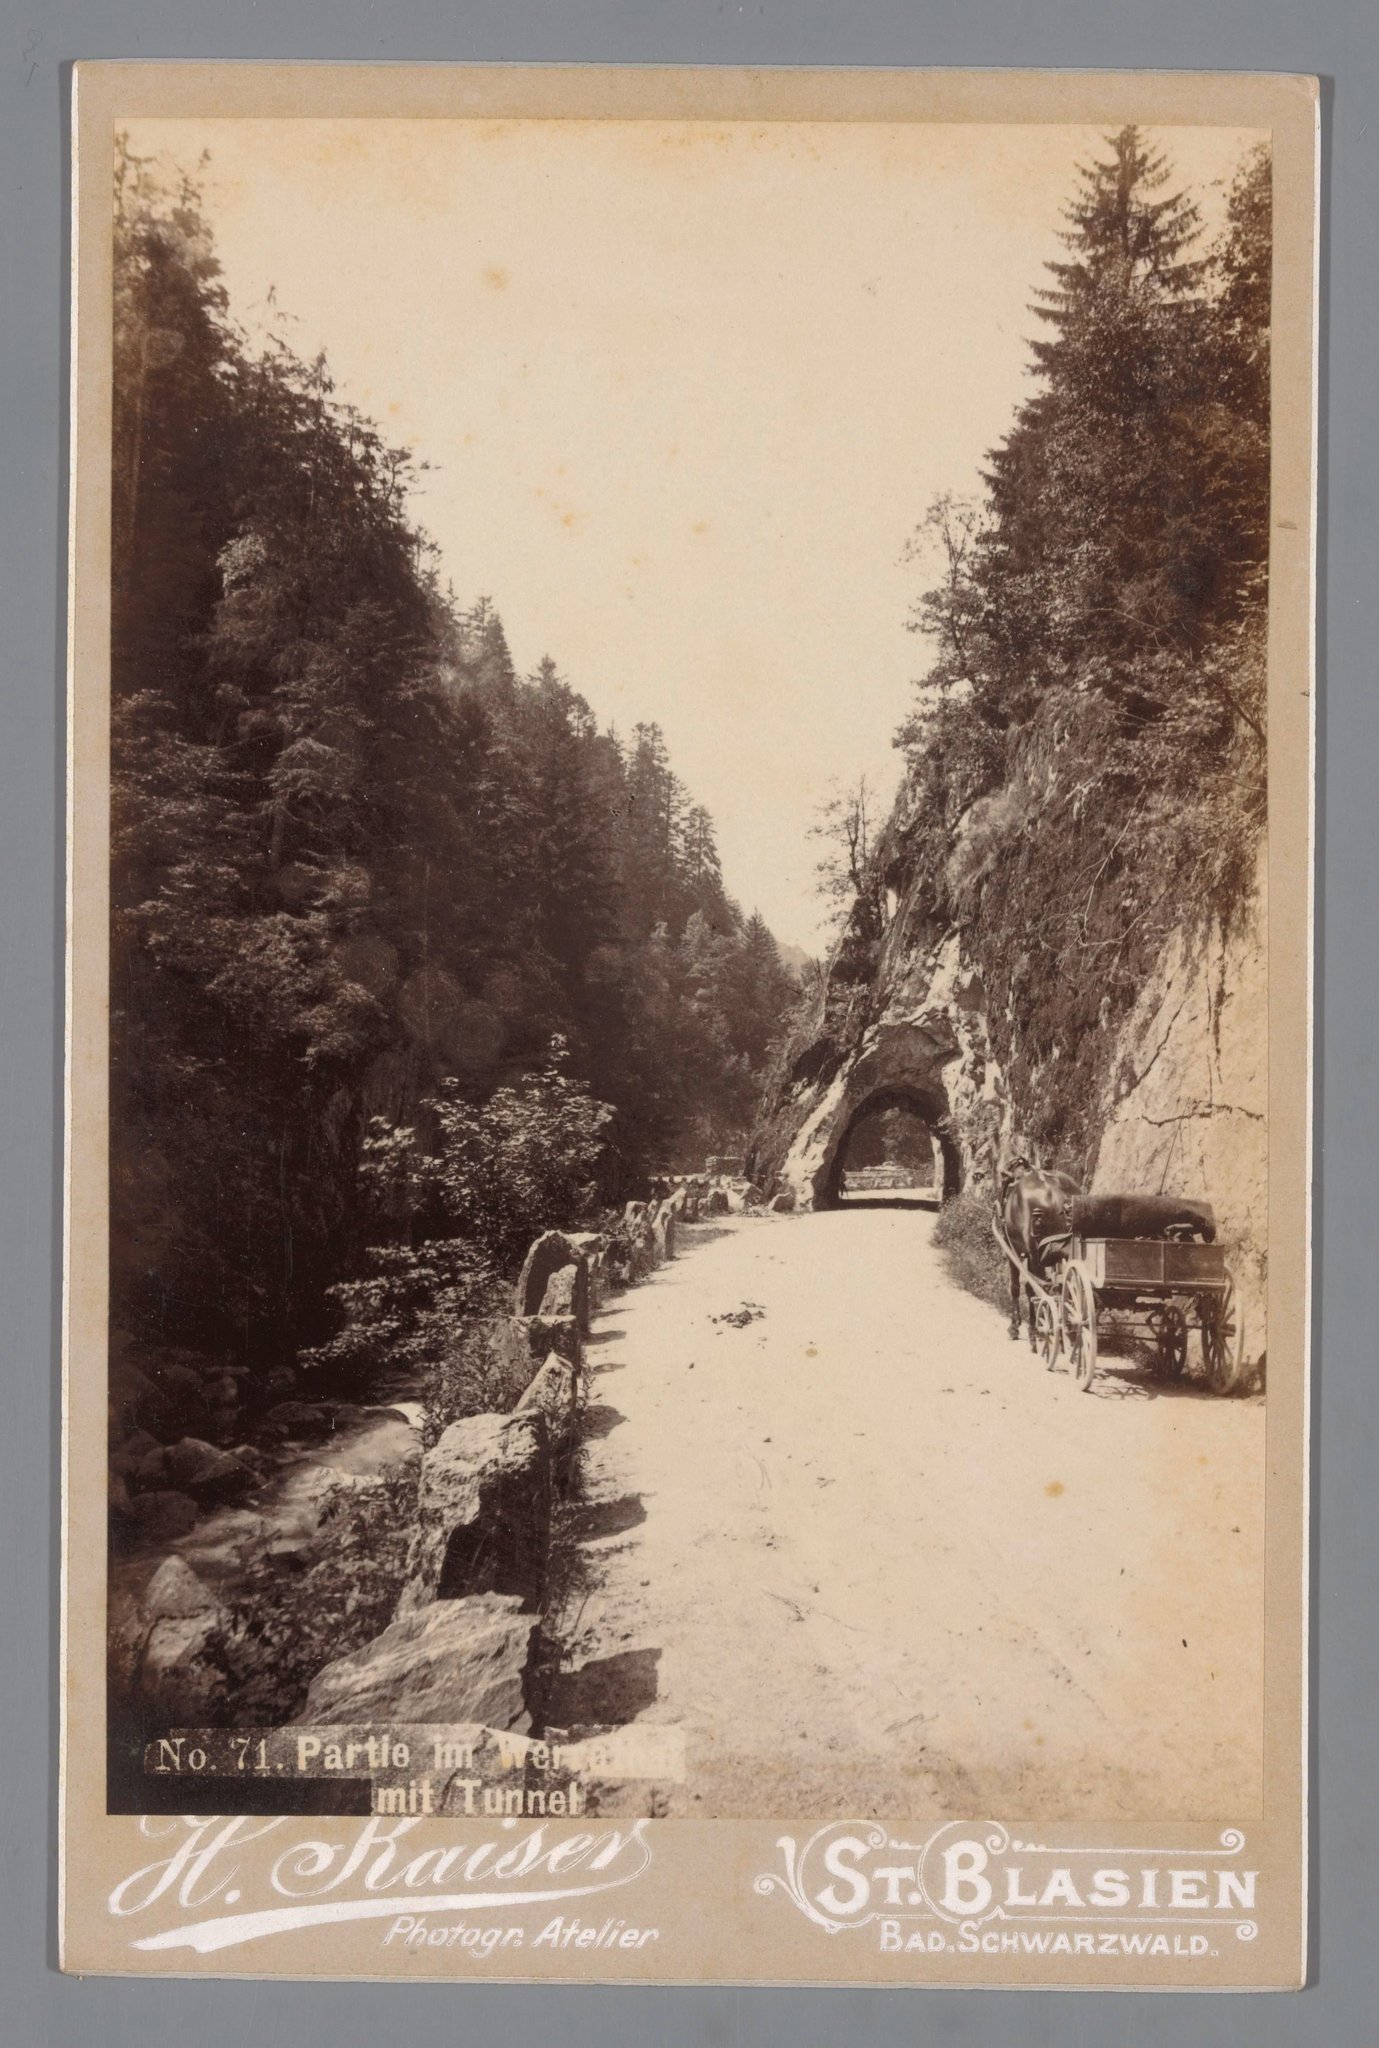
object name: photograph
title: St. Blasien Bad. Schwarzwald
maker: h. kaiser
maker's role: fotograaf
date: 1893-1900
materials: cardboard, photographic support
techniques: albumen print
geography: schwarzwald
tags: four-wheeled, animal-drawn vehicle, e.g.: cab, carriage, coach, road, path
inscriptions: number: ‘No. 71.’, inscription: ‘St. Blasien?’